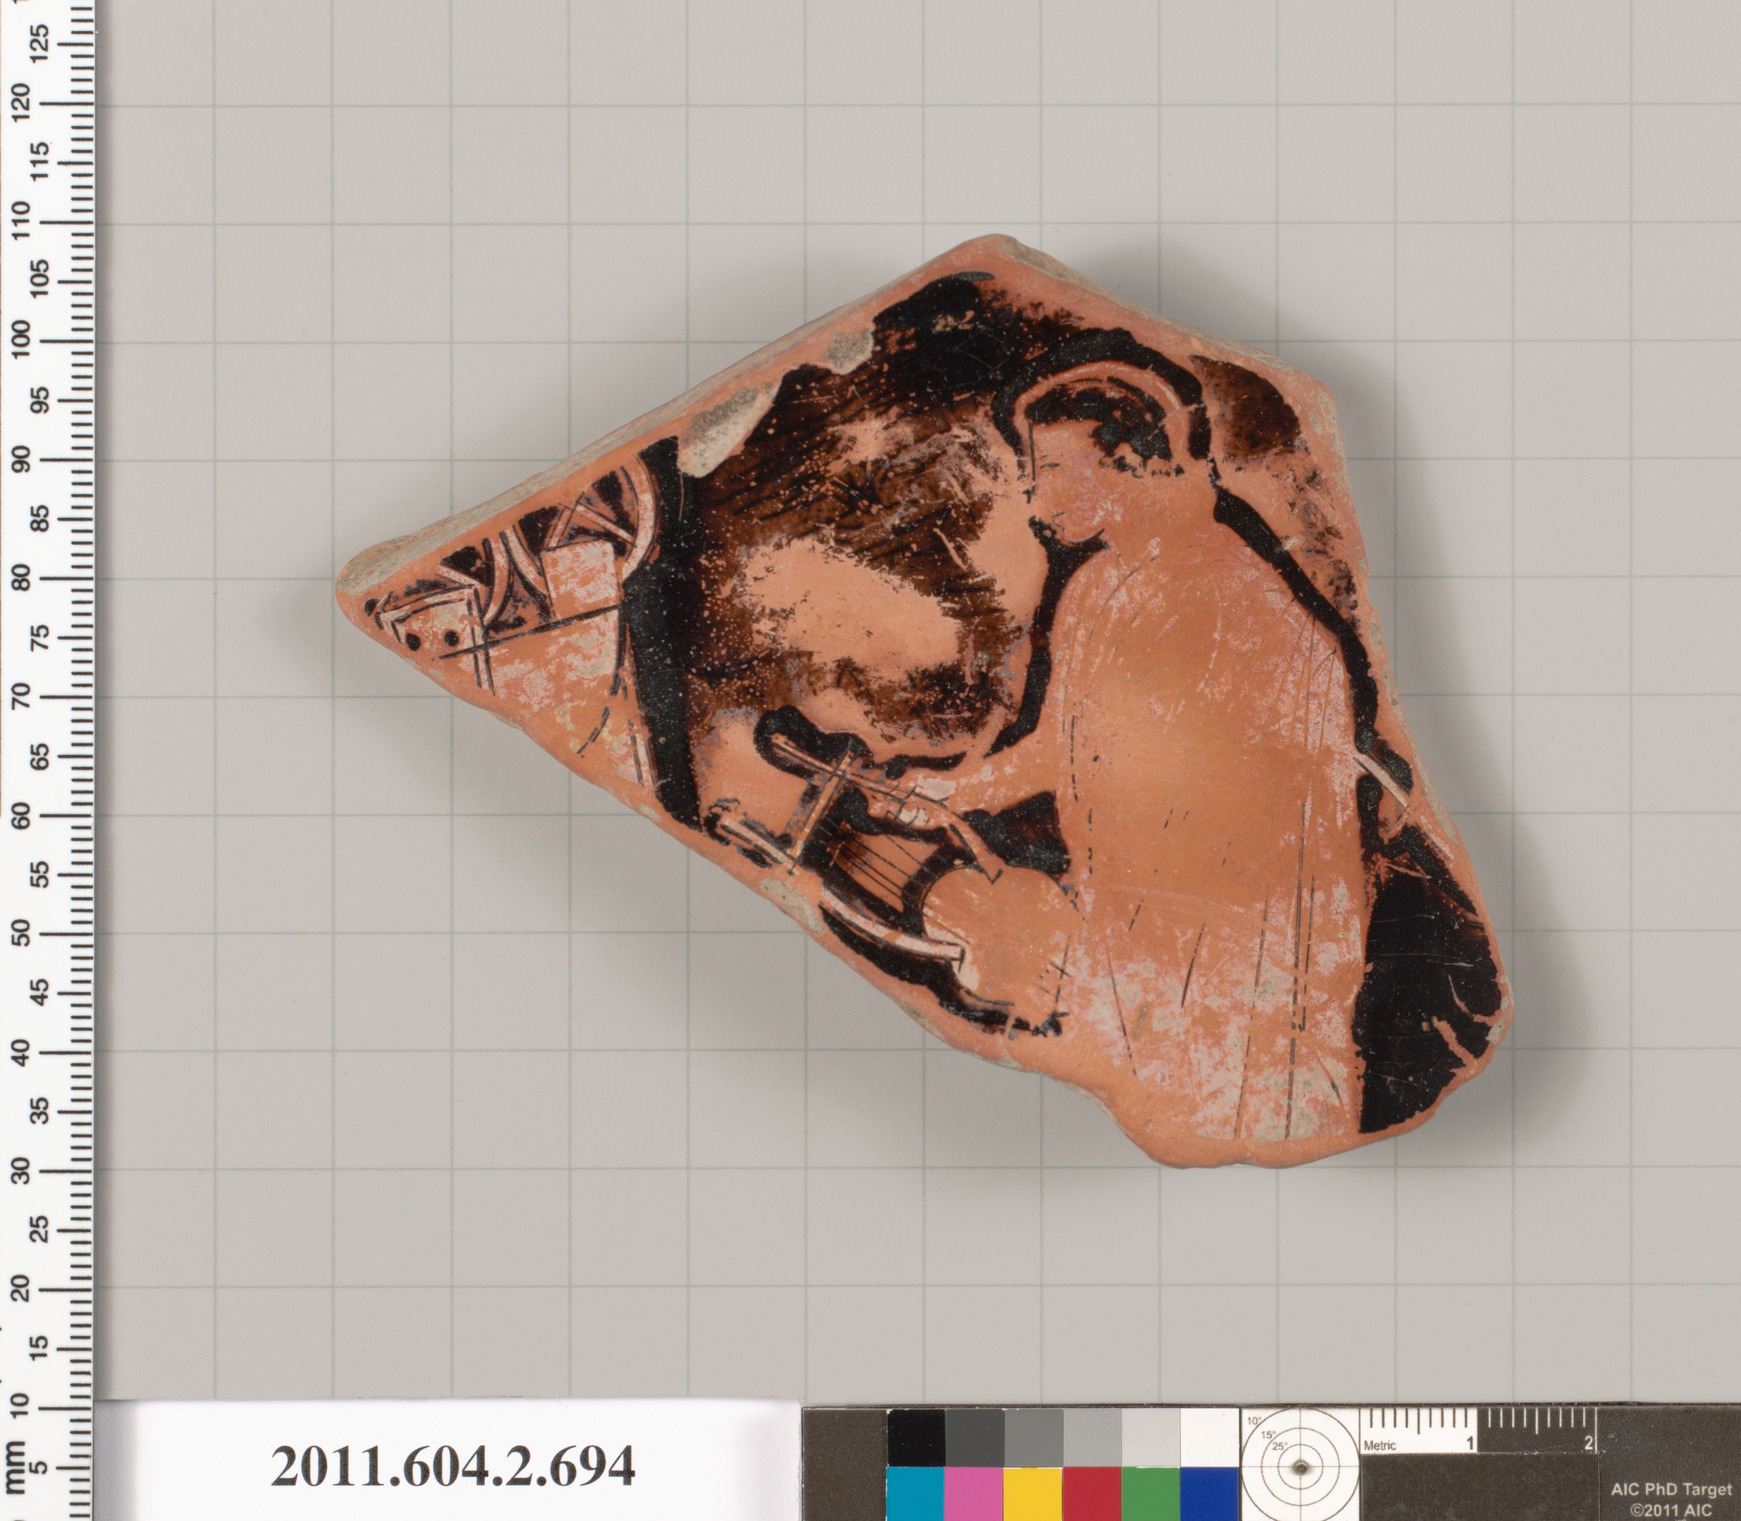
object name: calyx krater fragment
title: Terracotta fragment of a calyx-krater (bowl for mixing wine and water)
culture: greek, attic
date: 450-426 BCE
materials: terracotta